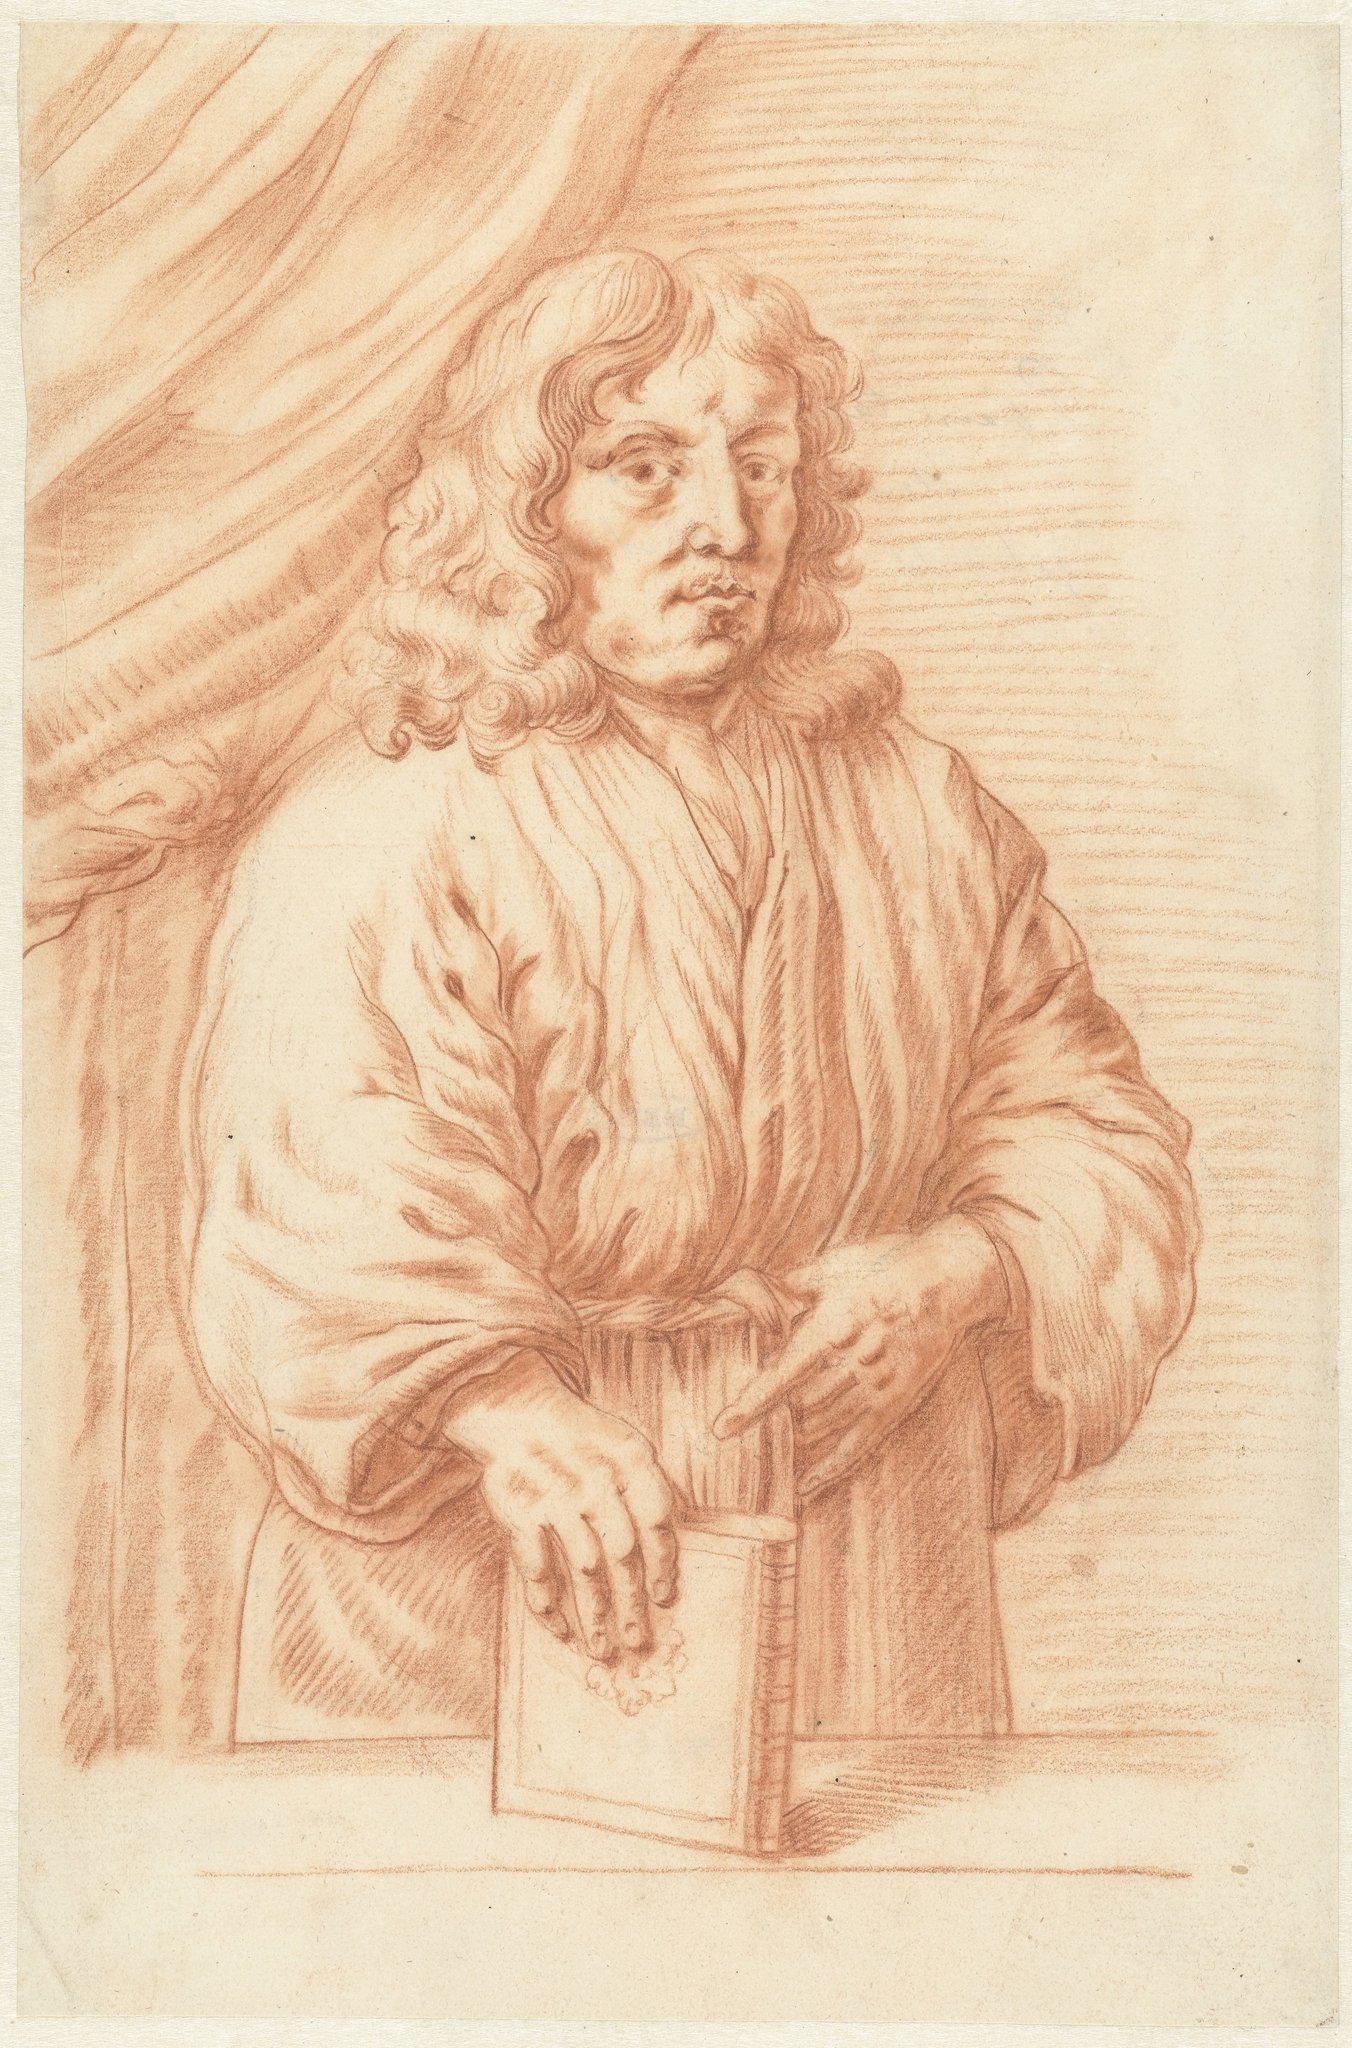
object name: drawing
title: Portret van Petrus van Staveren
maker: jan van munnickhuysen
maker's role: draughtsman, print maker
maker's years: 1655-1701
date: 1664-1710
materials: chalk, paper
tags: leiden, historical persons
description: Portret van Petrus van Staveren, predikant te Leiden.